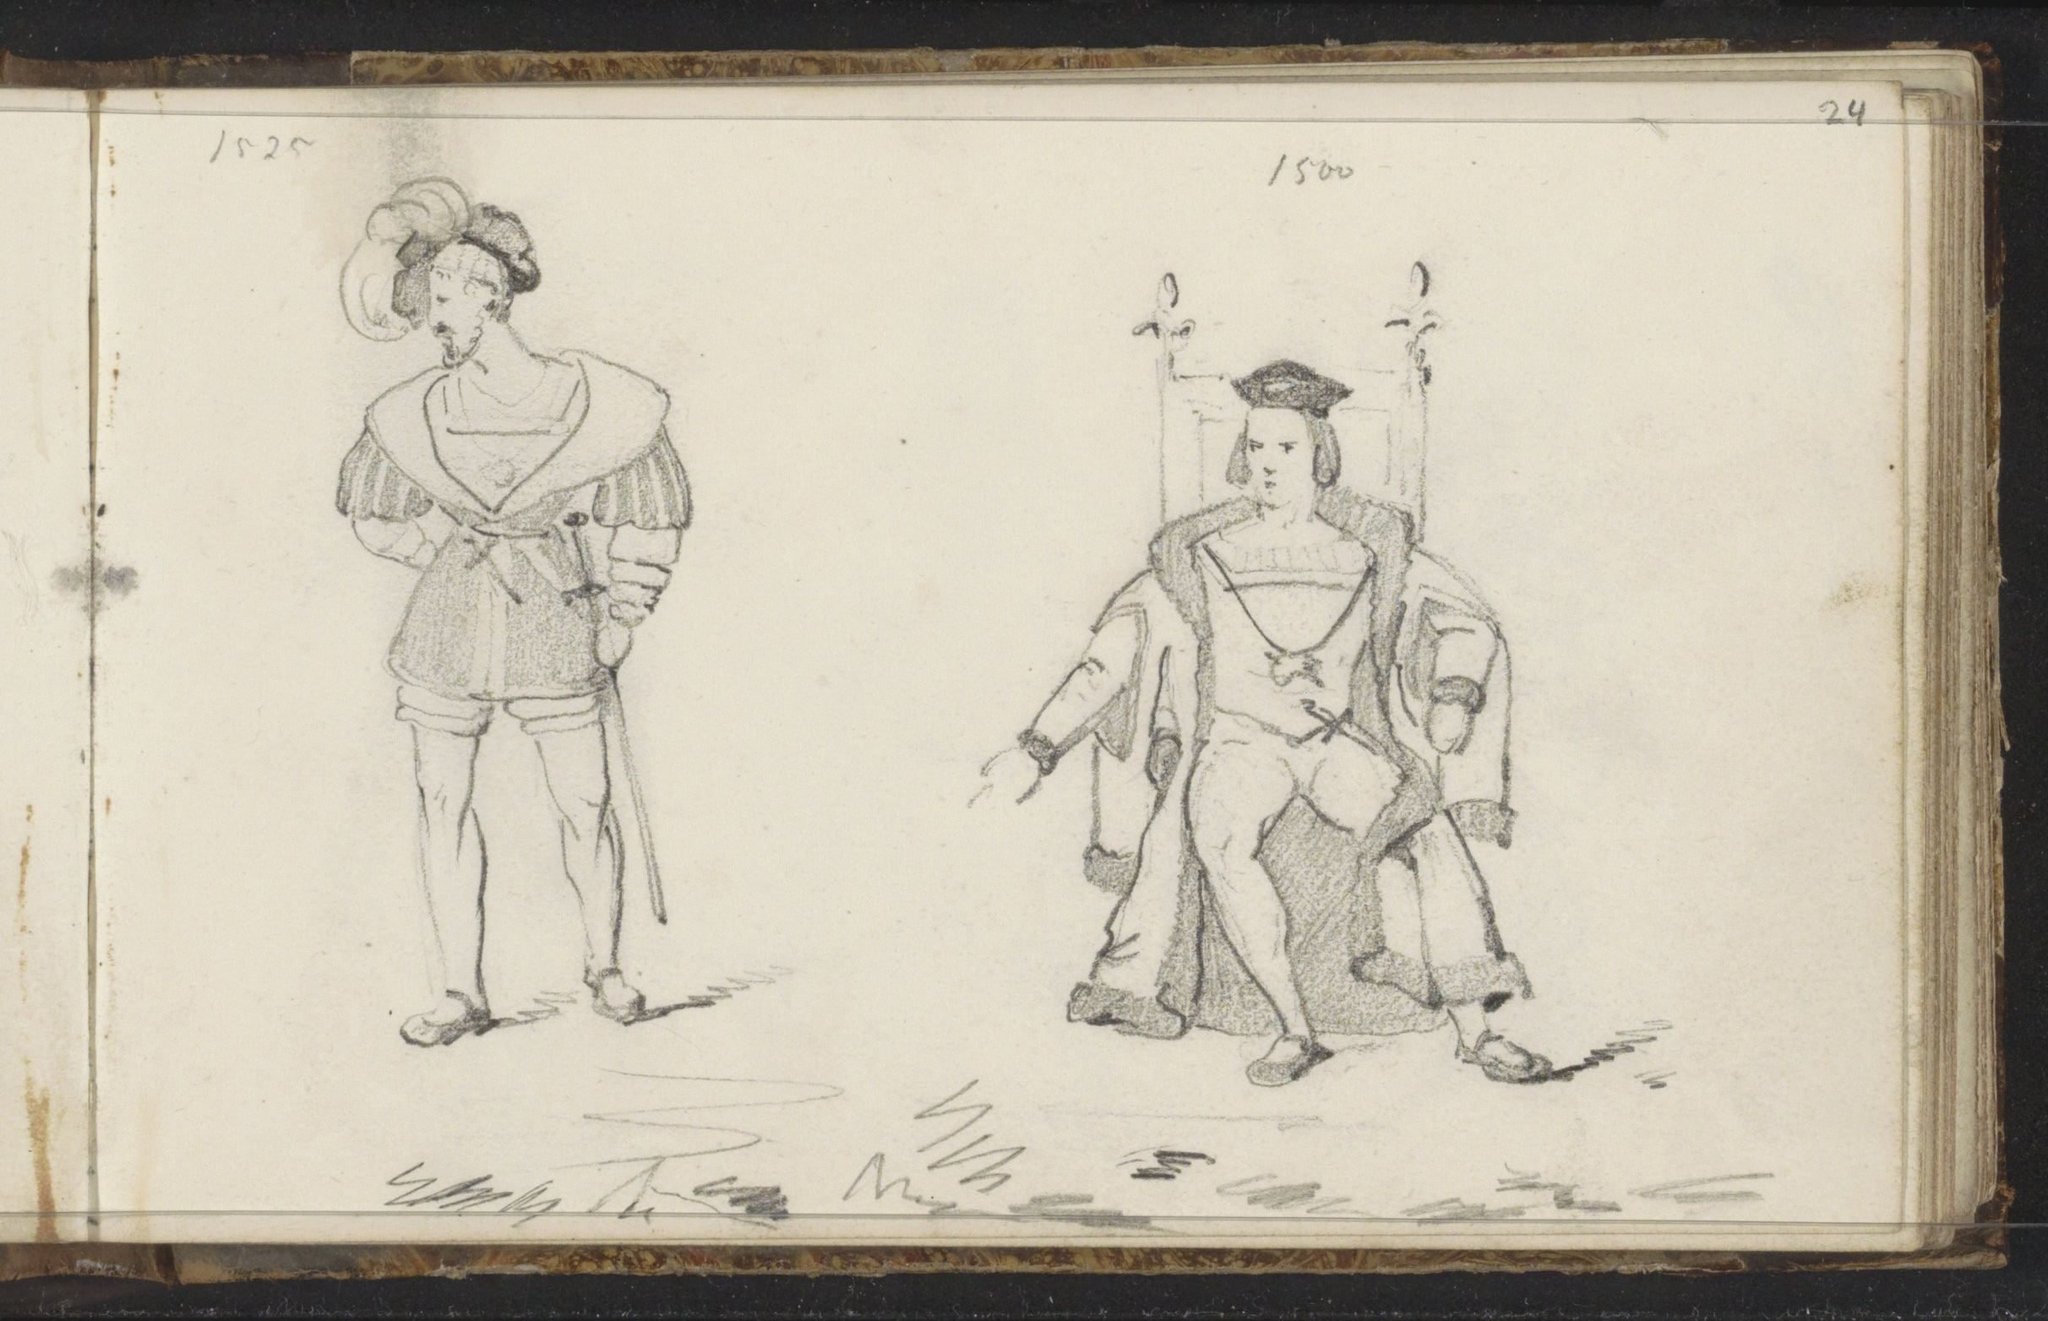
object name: sketchbook leaf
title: Twee mannen in historisch kostuum uit de periode 1500-1525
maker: willem hendrik schmidt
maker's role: draughtsman, painter, print maker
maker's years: 1809-1849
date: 1819-1849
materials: paper, pencil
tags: historical costume (+ men's clothes)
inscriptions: annotation: ‘1525 1500’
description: Blad 24 recto uit een schetsboek met 60 bladen.